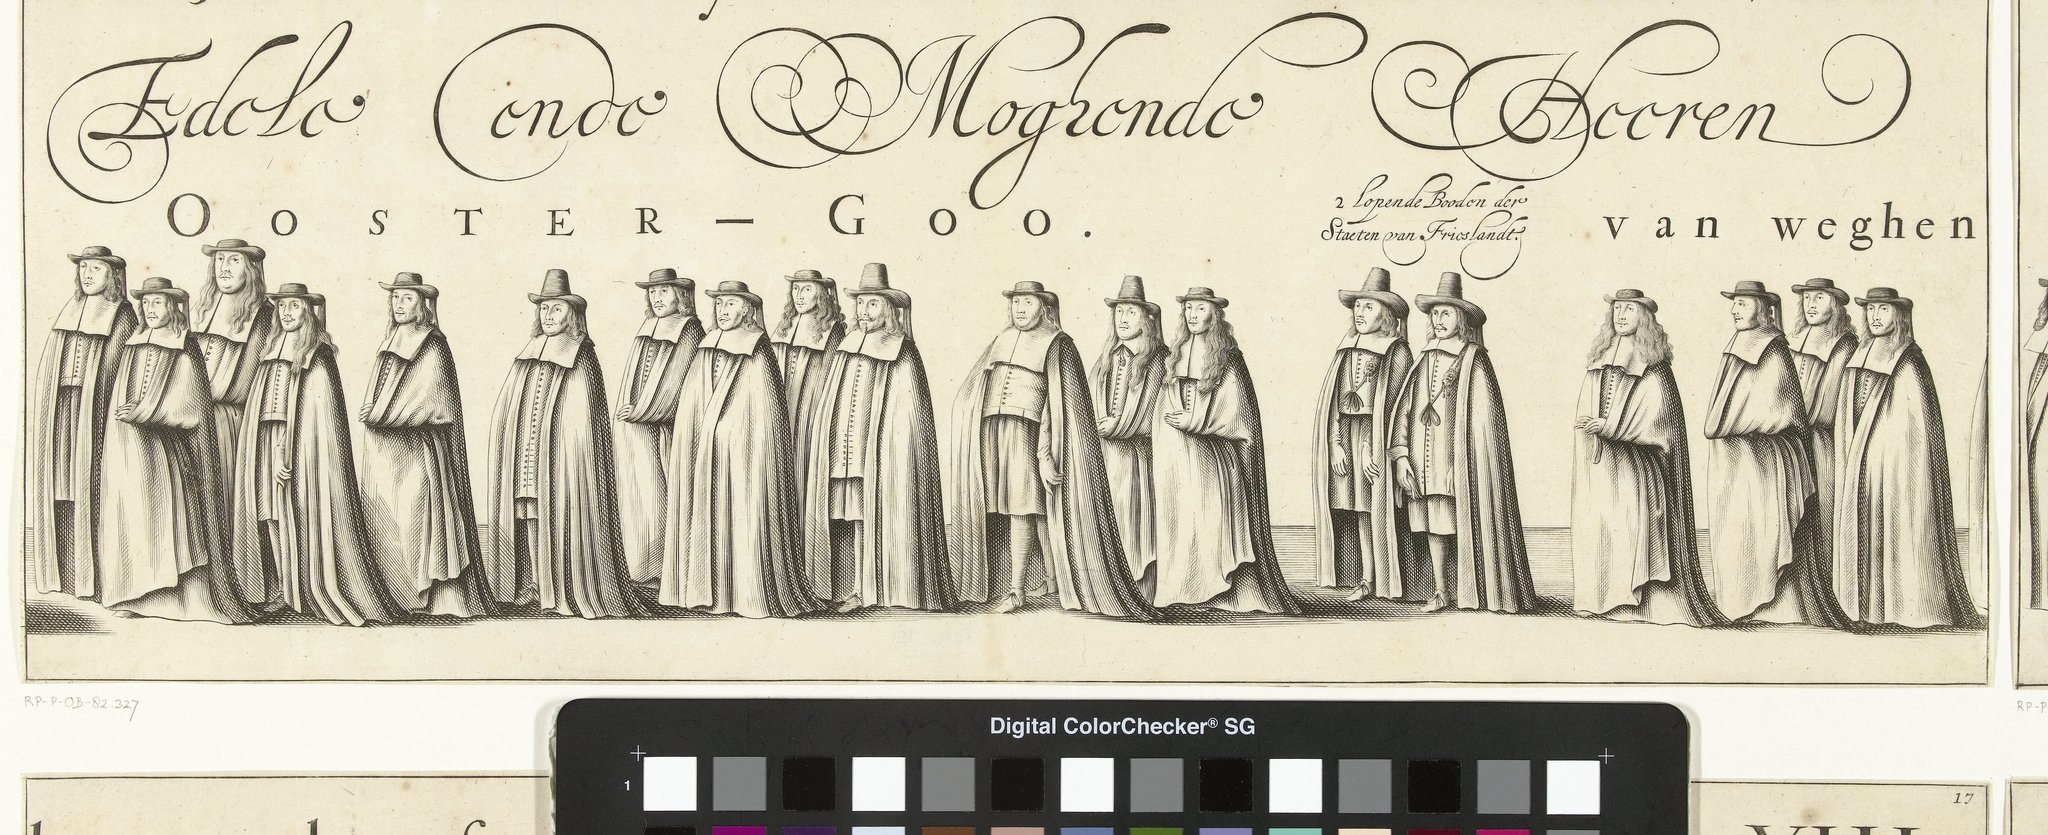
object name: print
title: Rouw-Staetelijcke Lijk-pracht in de Uyt-Vaert en Begraefenisse van het ont-zielde Lichaem van (...) Wilhelm Frederich (...) Overleden binnen Leeuwarden (...) den een-en-twintichsten October, MDCLXIV. en aldaer in 't Choor van de Jacobijner Kerck, den vyfthienden december MDCLXIV. Oude Stijl (...)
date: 1666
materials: paper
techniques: engraving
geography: leeuwarden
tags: cortege, funeral procession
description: Begrafenisoptocht van Willem Frederik, graaf van Nassau-Dietz, in Leeuwarden op 6 januari 1665. Deel van de begrafenisstoet. Plaat nr. 15 in een ensemble van 24 (van de 25) ongemonteerde genummerde platen (zonder tekstbladen) die samen een lange fries vormen.